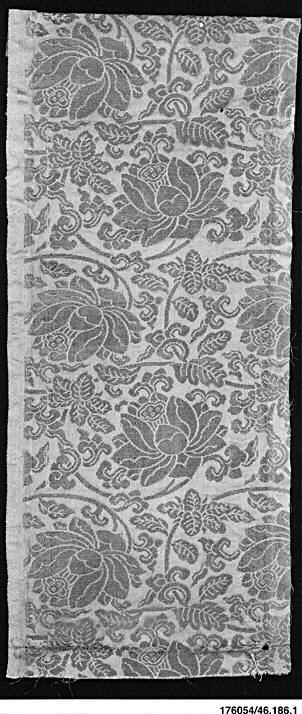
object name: sutra cover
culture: chinese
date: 1601-1700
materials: silk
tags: lotuses